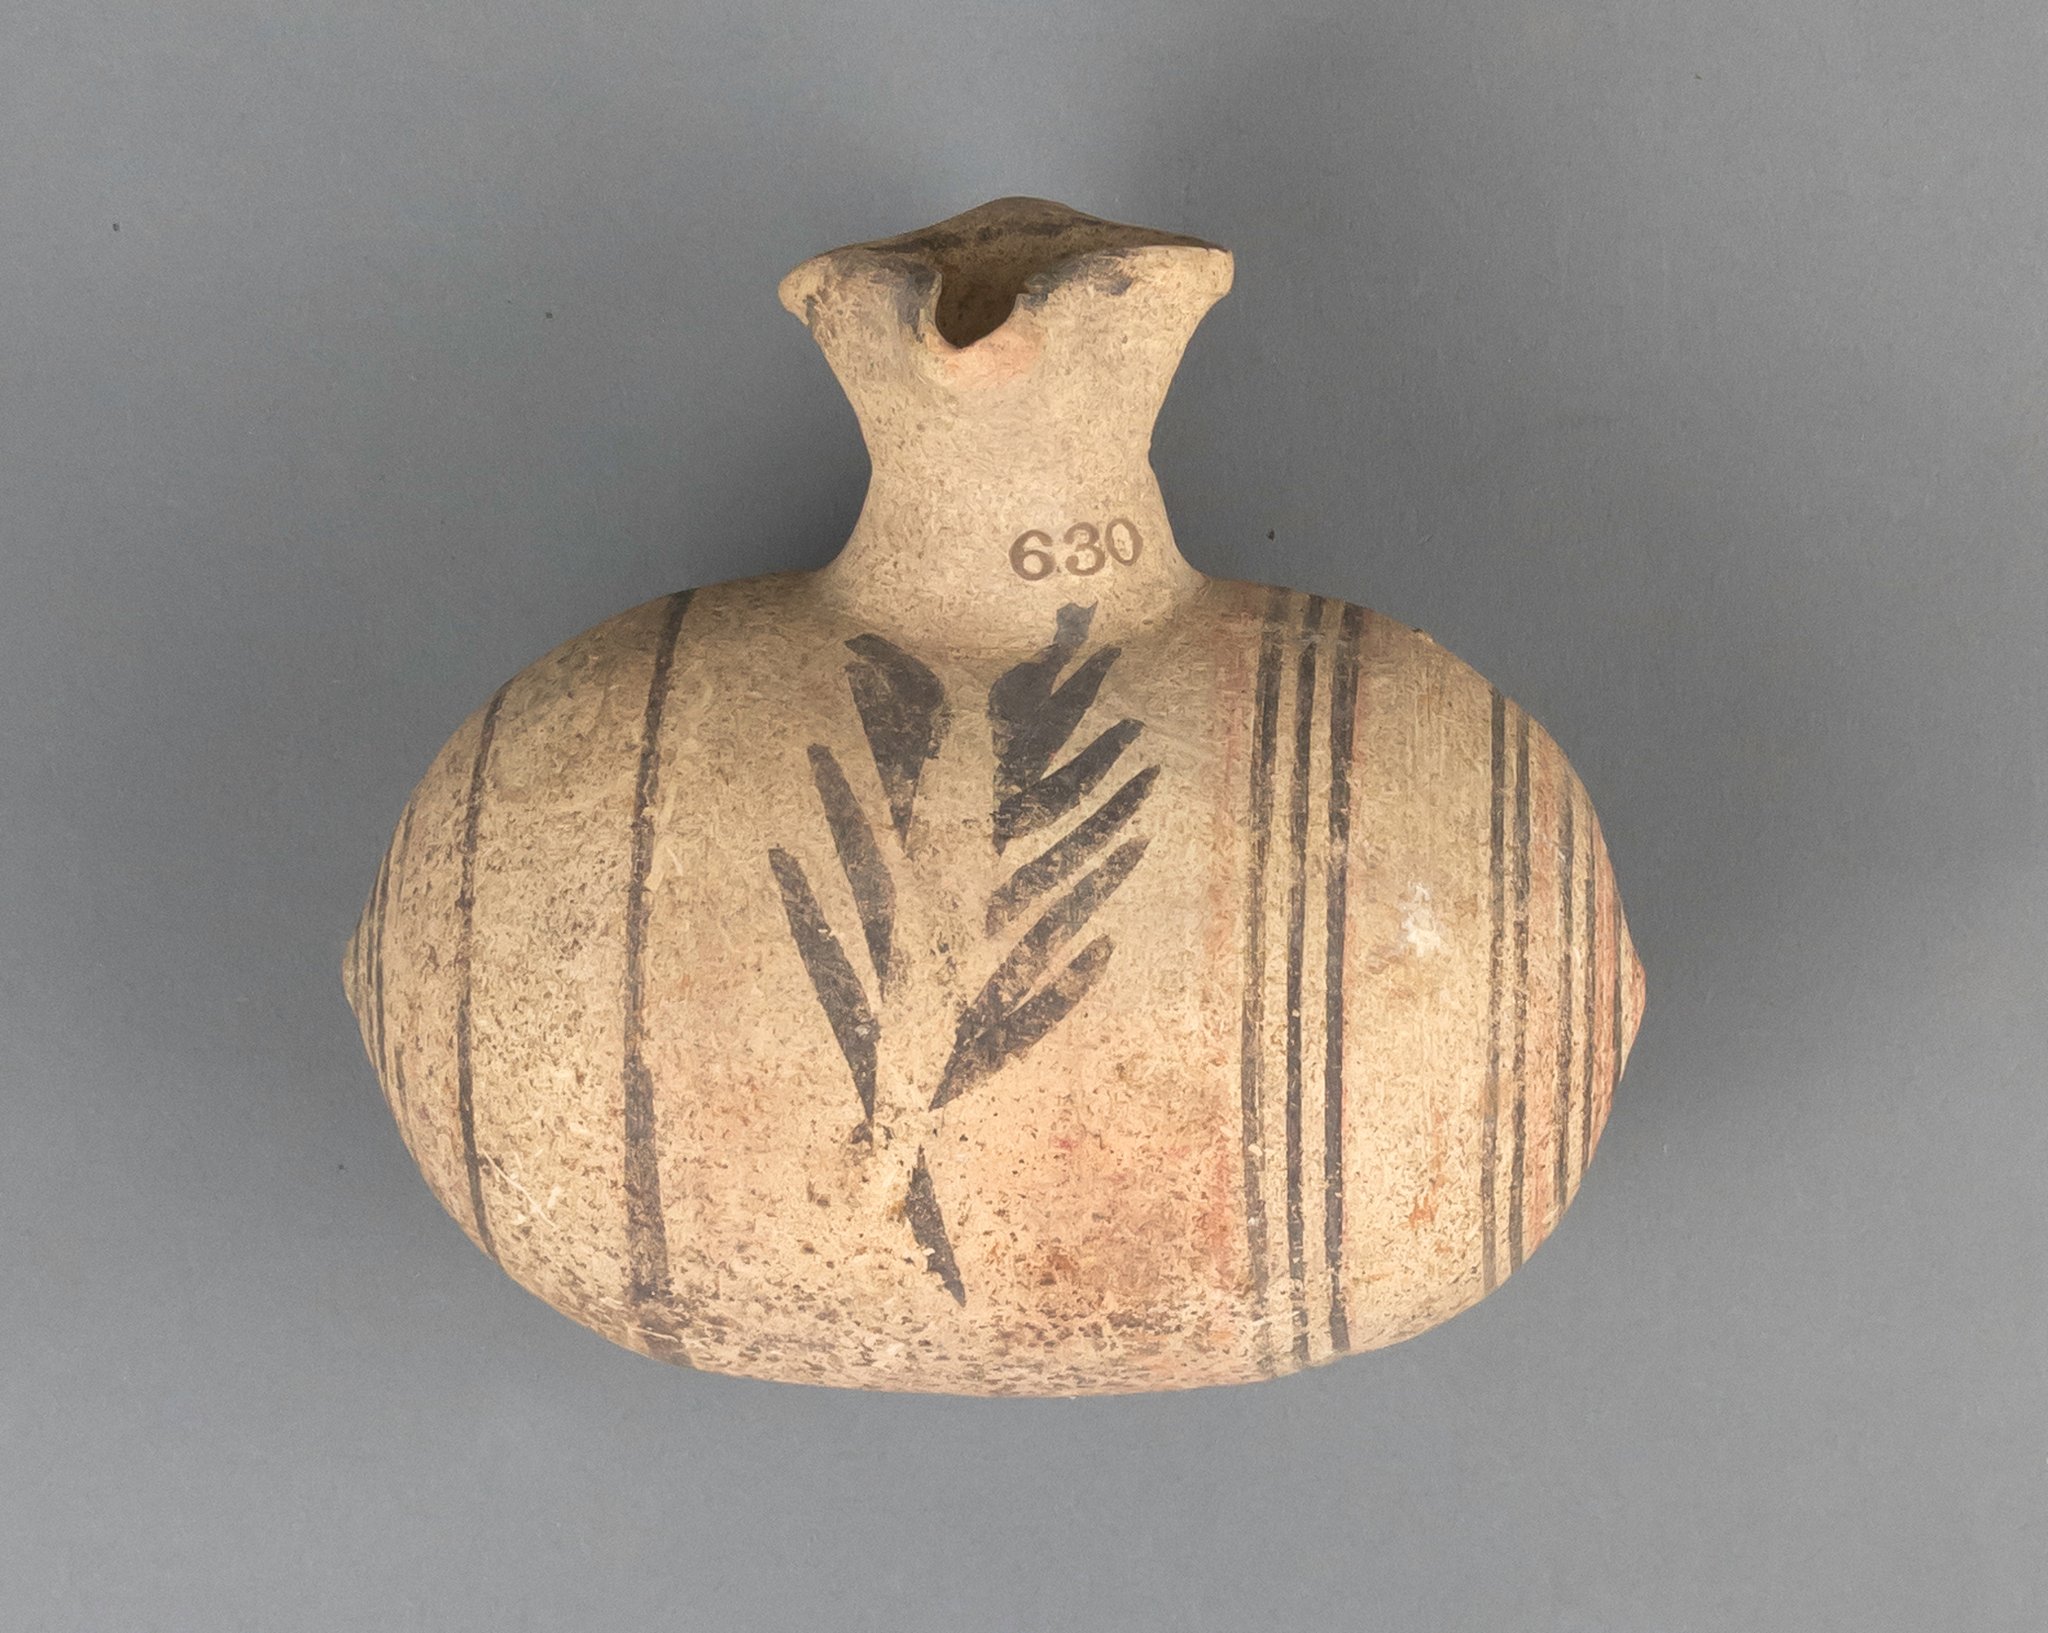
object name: jug, barrel shaped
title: Jug, barrel-shaped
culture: cypriot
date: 600-480 BCE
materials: terracotta